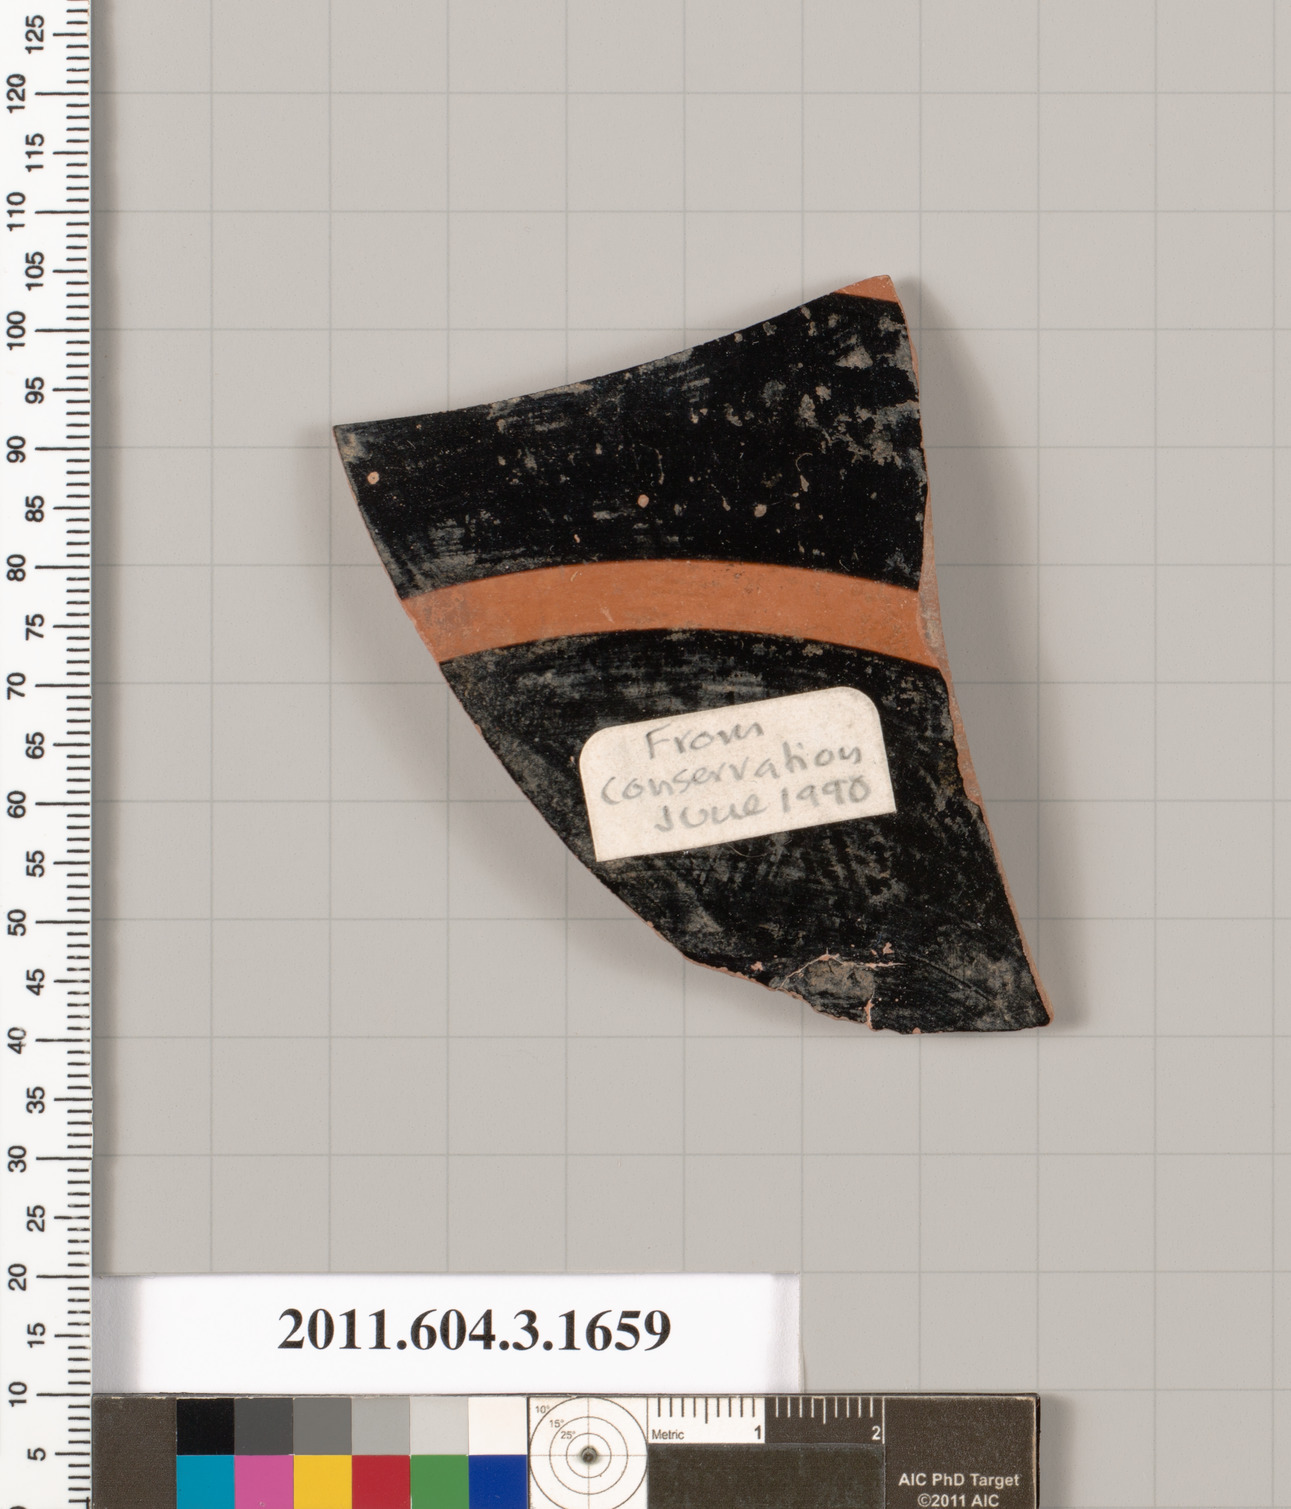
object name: kylix fragment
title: Terracotta fragment of a kylix: Band or lip cup (drinking cup)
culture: greek, attic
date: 550-526 BCE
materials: terracotta